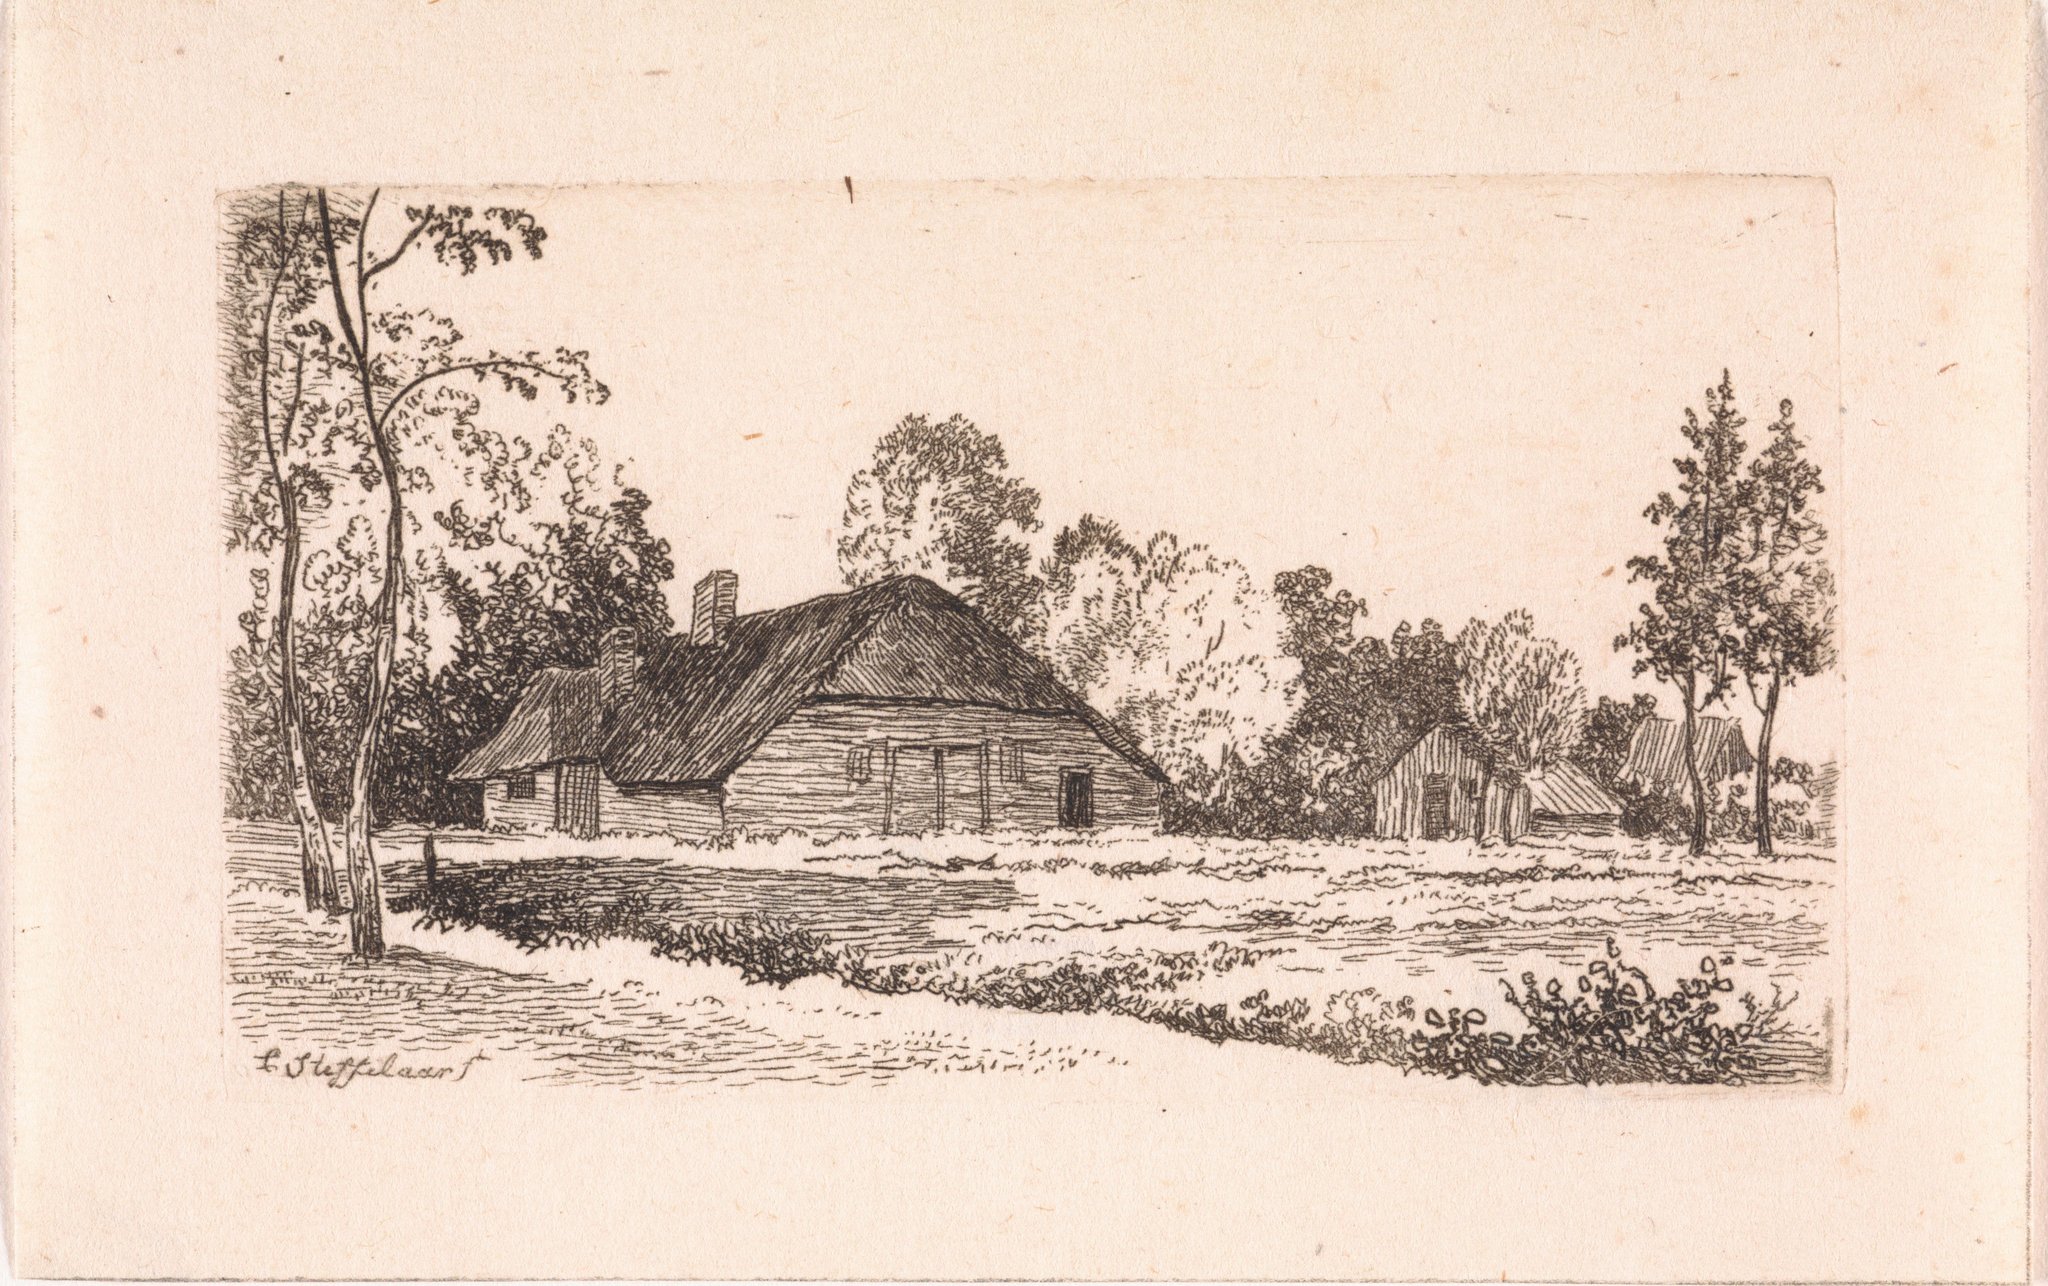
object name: print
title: Tweede suite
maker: cornelis steffelaar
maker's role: draughtsman, painter, print maker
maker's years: 1797-1861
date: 1845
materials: paper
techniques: etching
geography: amsterdam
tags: rural housing, e.g. country-house, villa, cottage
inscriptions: collector's mark: Lugt 2228